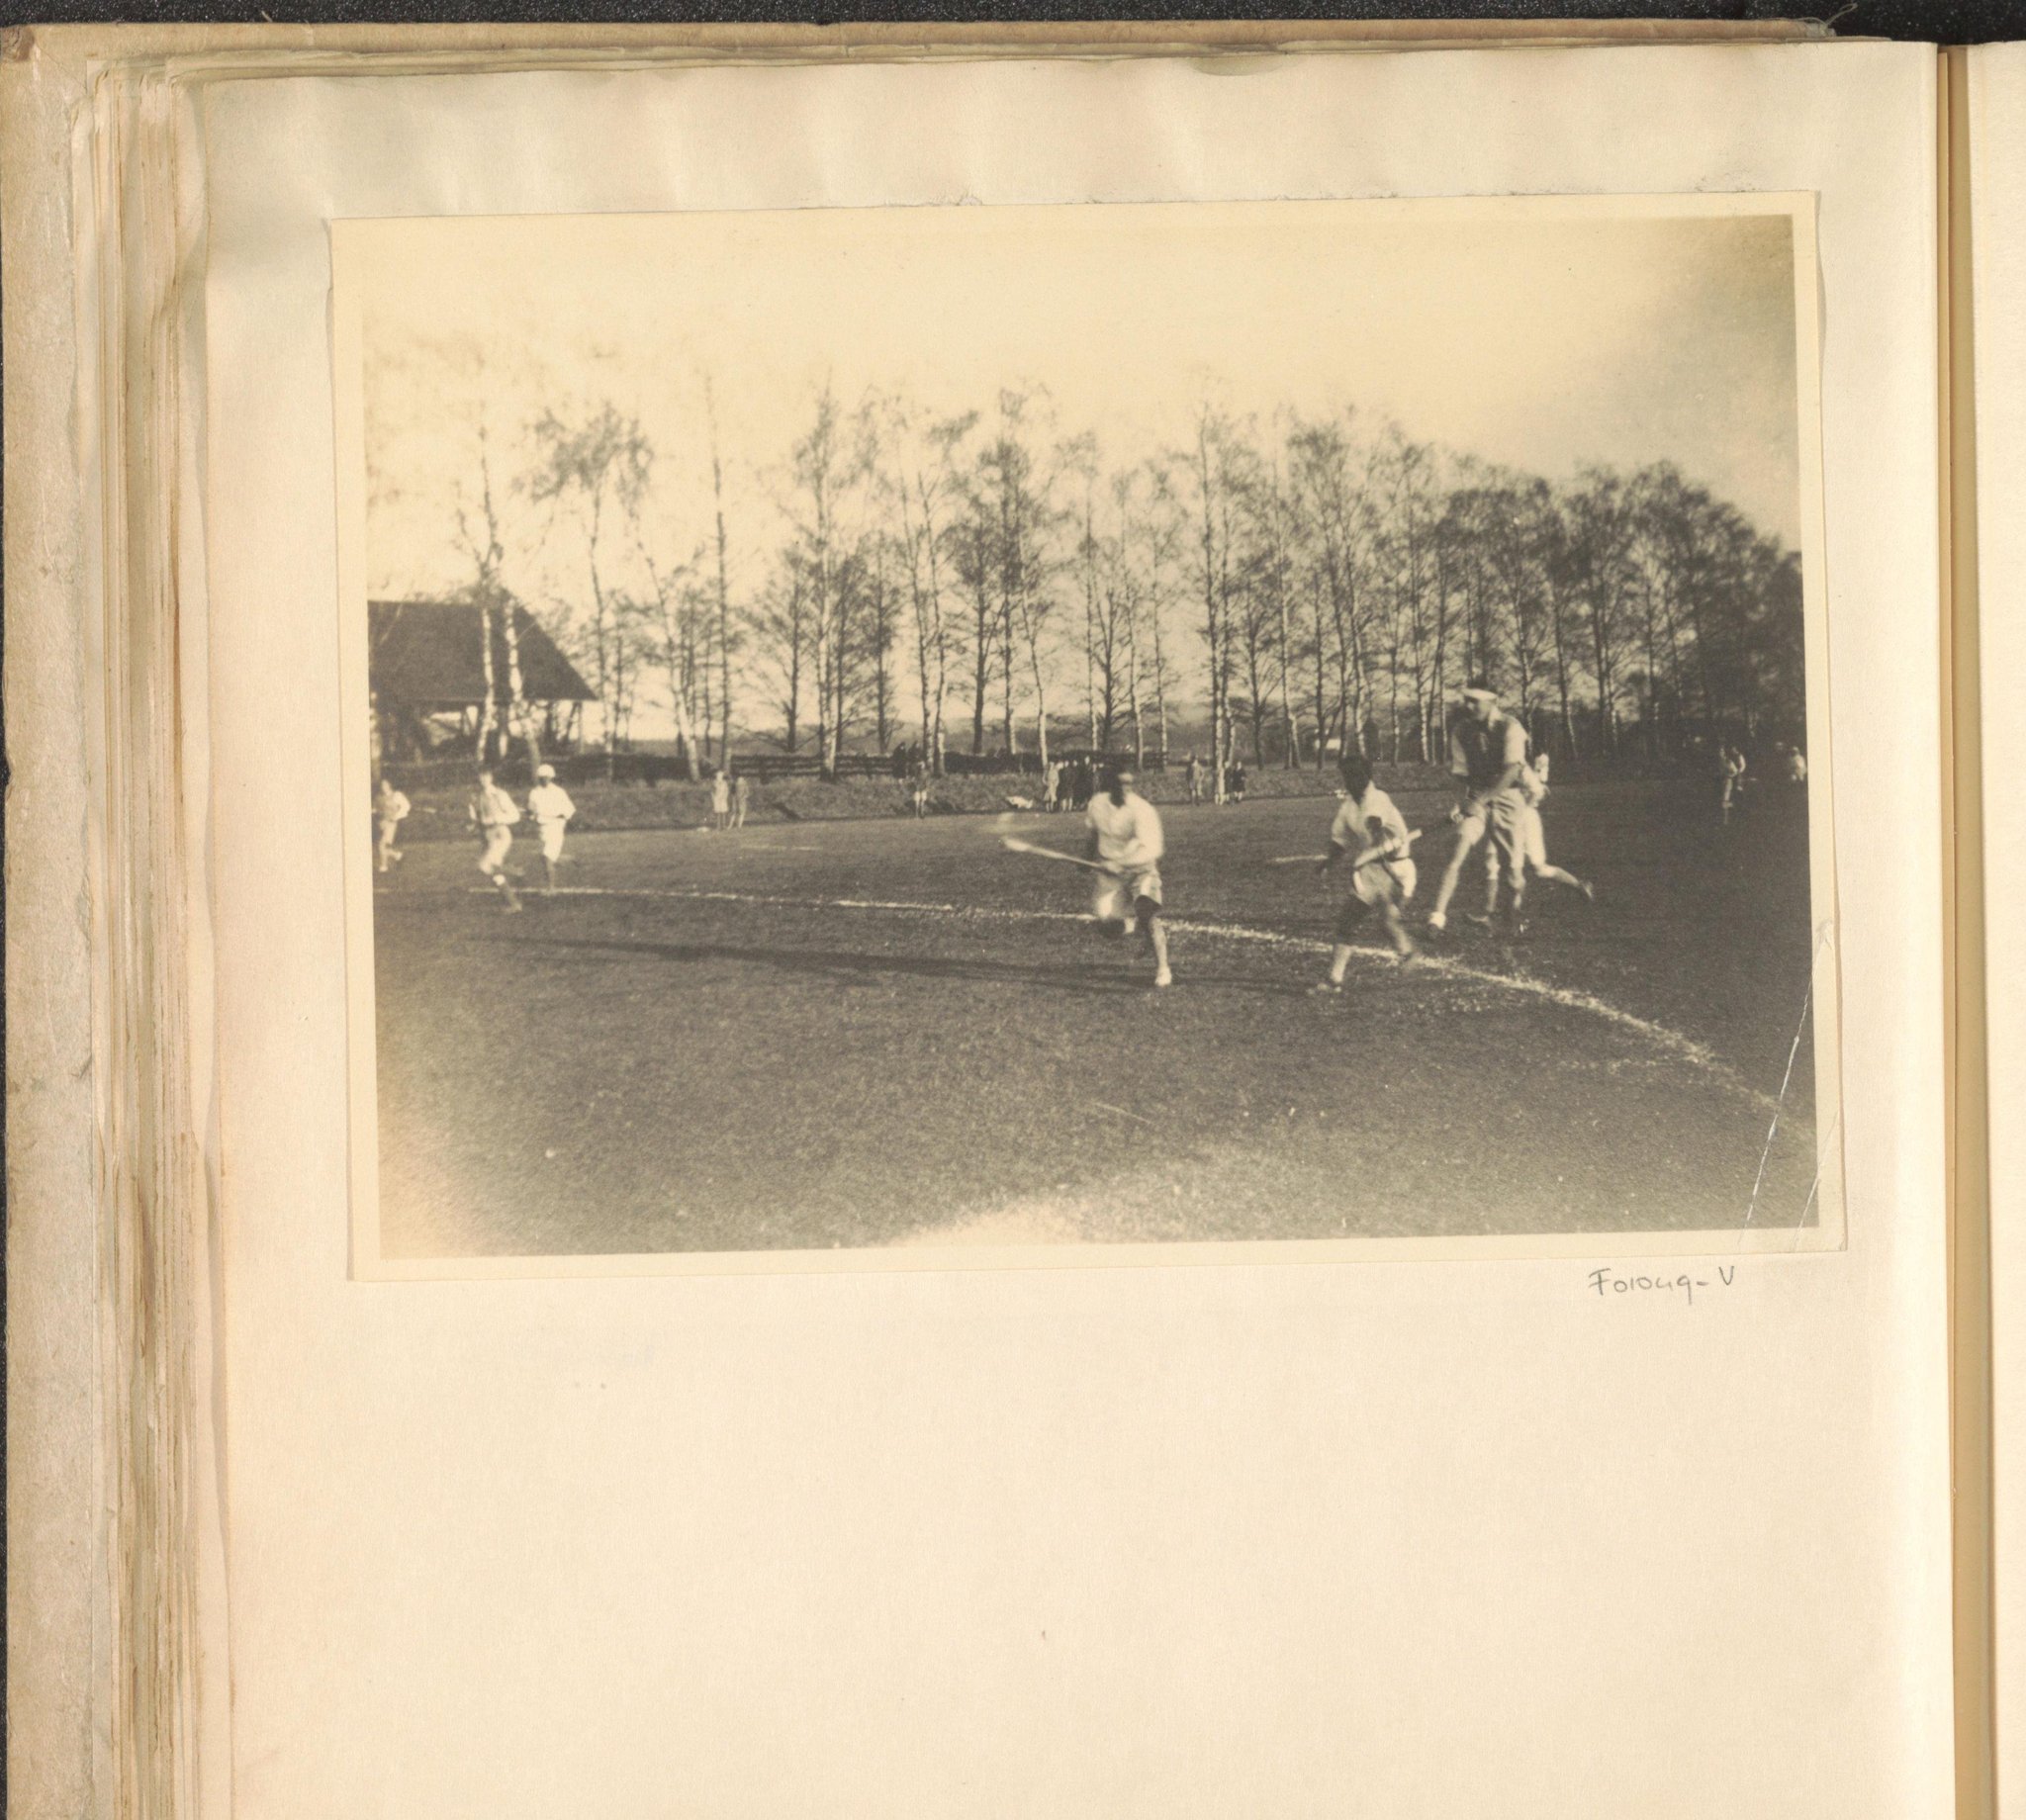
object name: photograph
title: Hockeyende leerlingen van Schule Schloss Salem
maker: Anonymous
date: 1929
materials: photographic support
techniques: gelatin silver print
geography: salem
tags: hockey (+ sportsman, player, etc.), education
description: Onderdeel van Fotoalbum van Schule Schloss Salem.